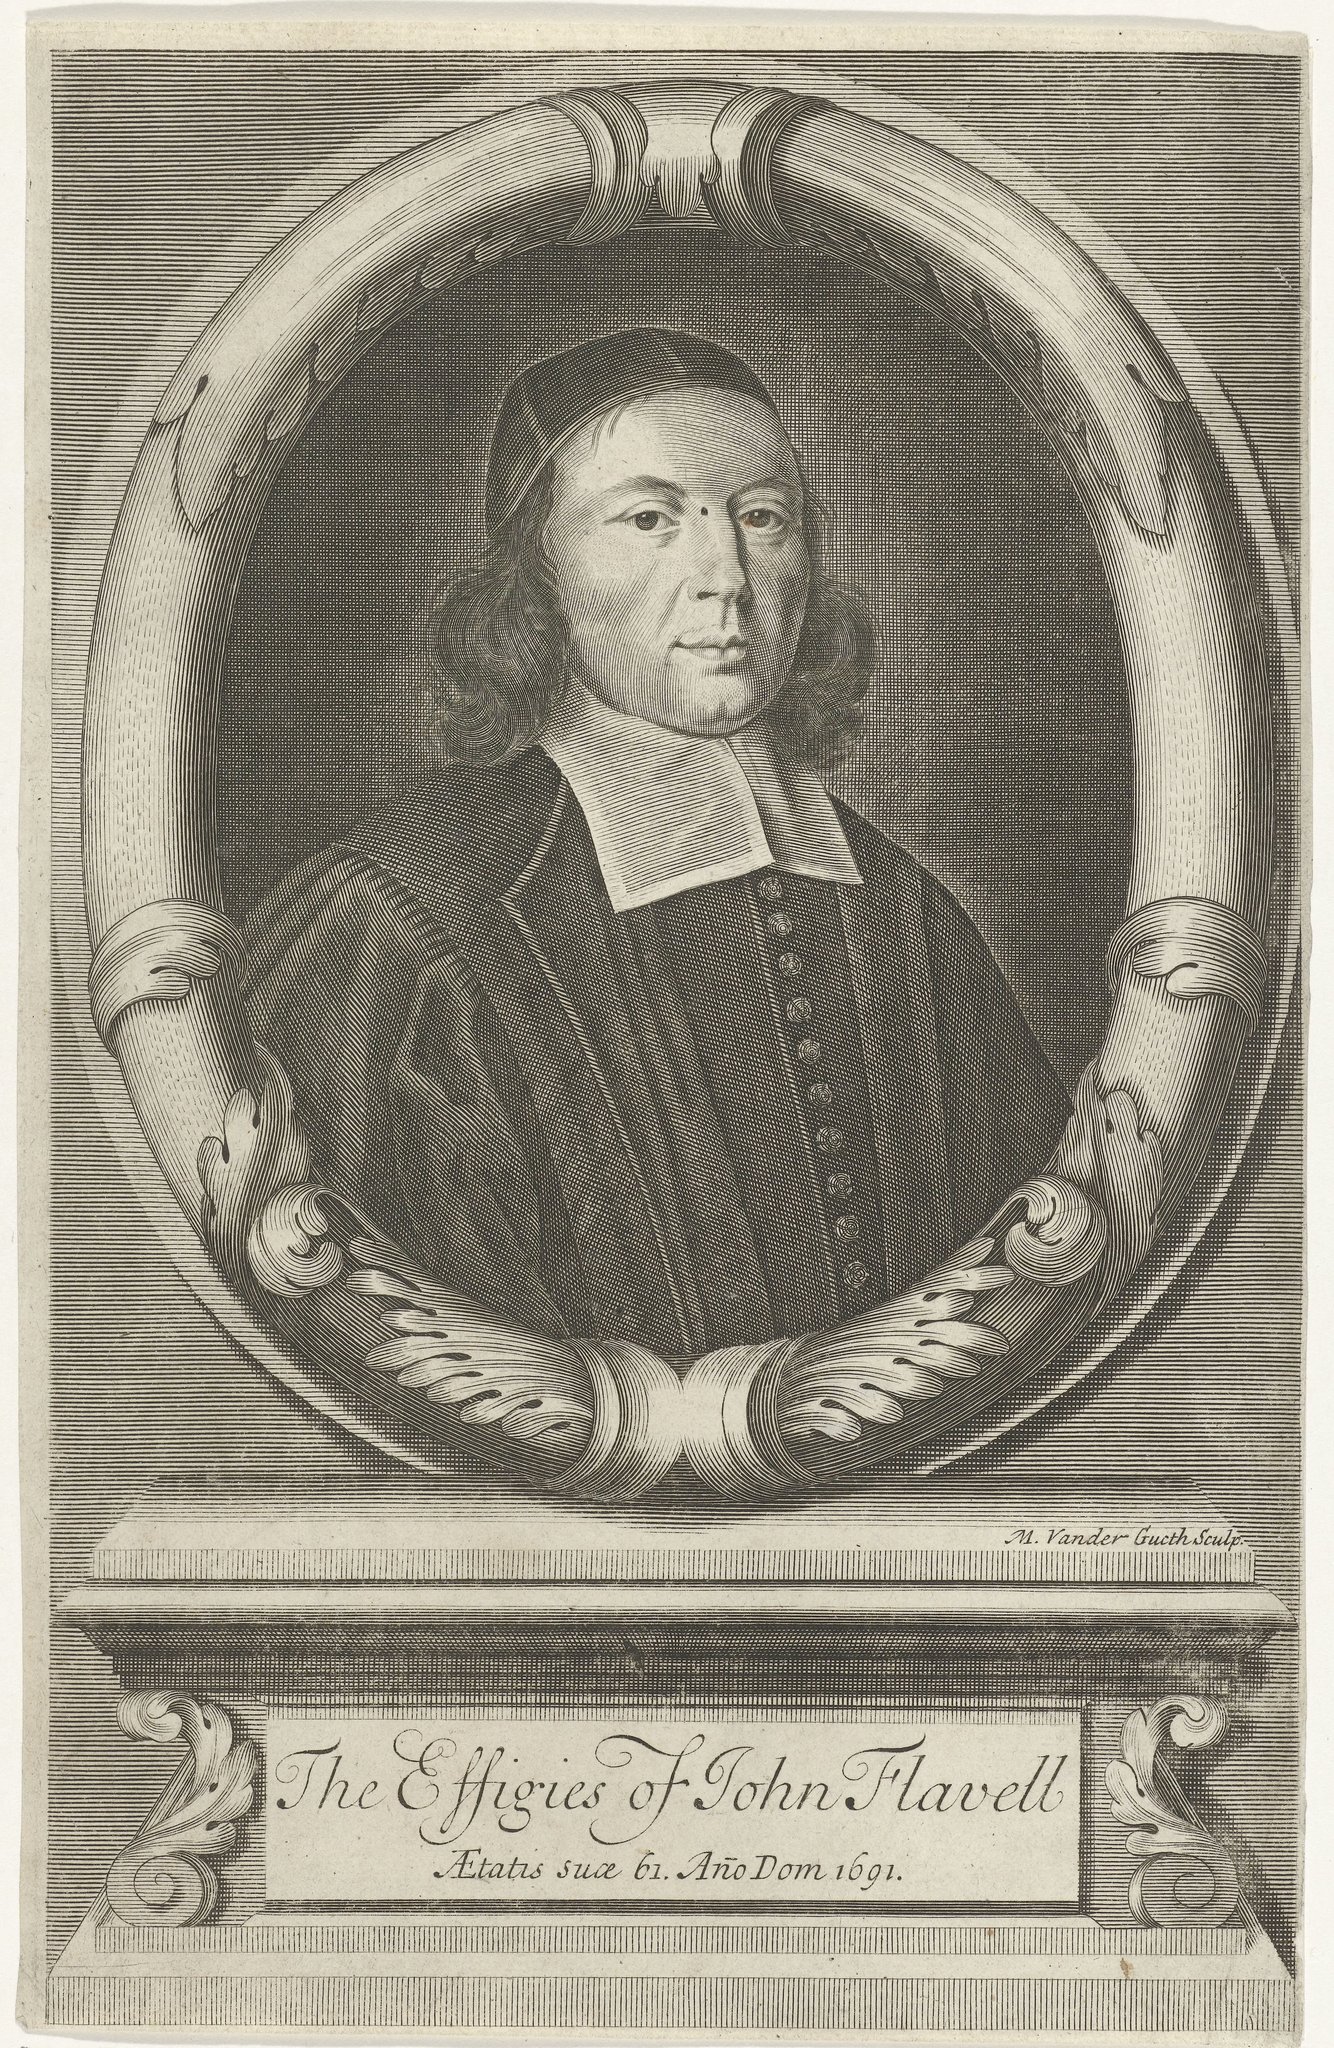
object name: print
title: Portret van John Flavel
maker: michiel van der gucht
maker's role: print maker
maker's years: 1660-1725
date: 1670-1725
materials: paper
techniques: engraving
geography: antwerp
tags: bromsgrove, predikant, john flavel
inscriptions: collector's mark: Lugt 2228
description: Busteportret van John Flavel in toga, met kalot. Het portret is gevat in een ovale omlijsting. In een kader op het piëdestal de naam en geboorte- en sterfdata van de geportretteerde.